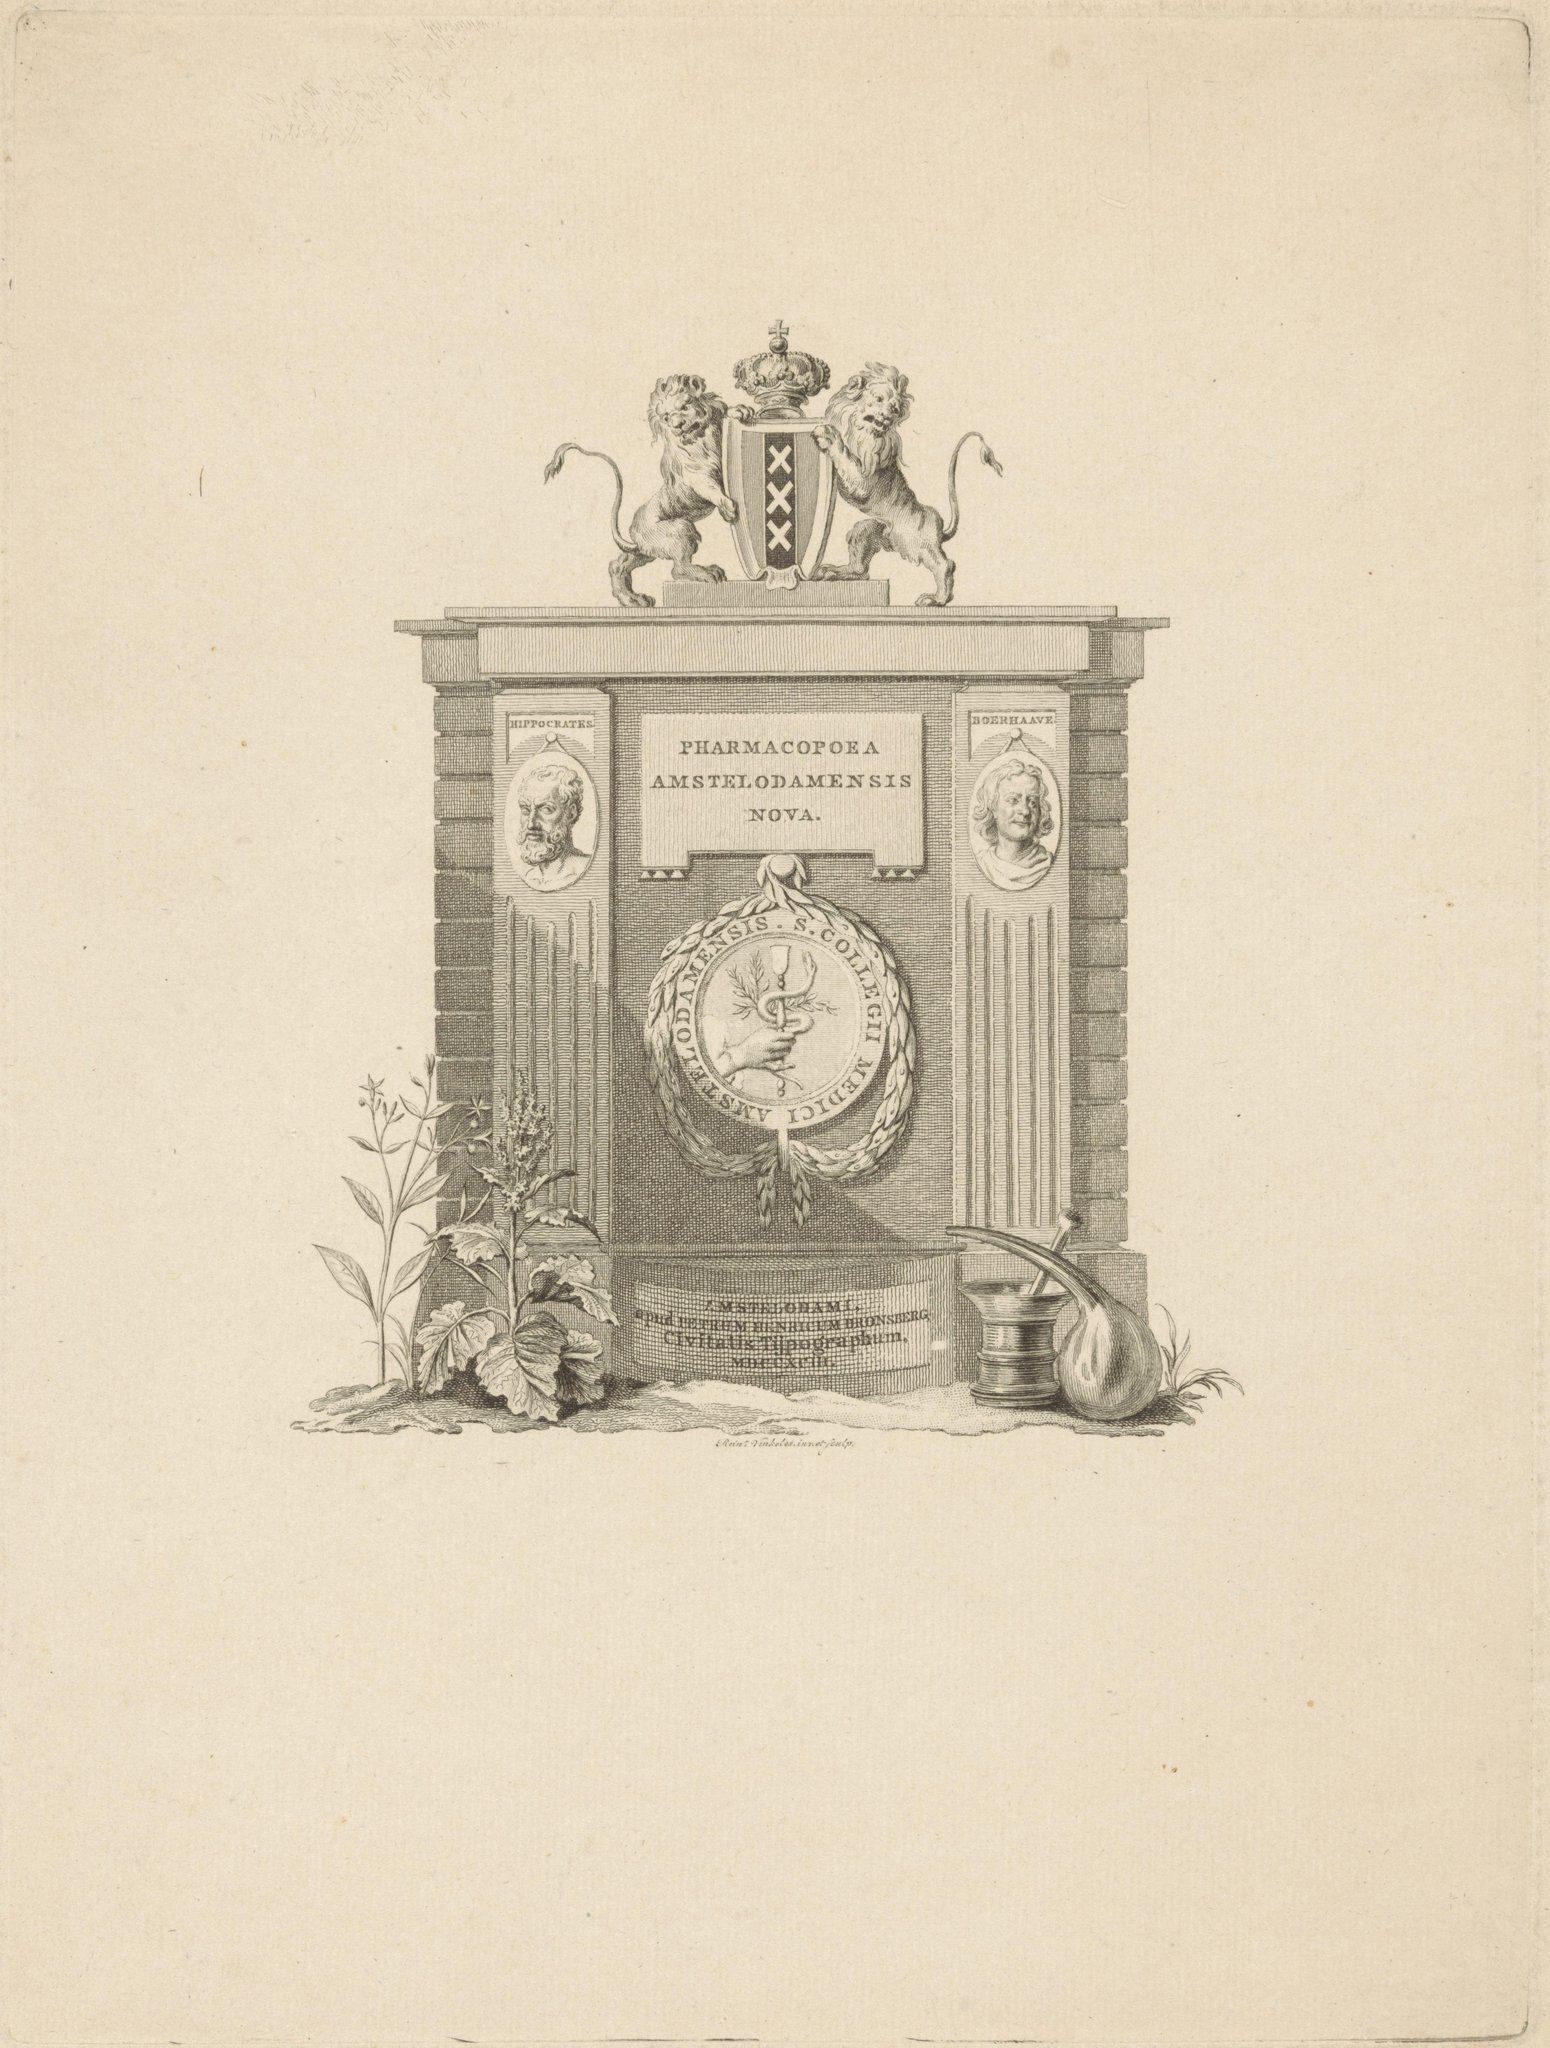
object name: titelblad, titelpagina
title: Titelpagina van de Pharmacopoea Amstelodamensis Nova, 1792-1793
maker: reinier vinkeles (i)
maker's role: draughtsman, print maker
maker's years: 1741-1816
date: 1792-1793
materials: paper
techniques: etching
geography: amsterdam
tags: hermanus boerhaave, pharmacy, pharmaceutics, (story of) hippocrates, amsterdam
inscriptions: collector's mark: Lugt 2228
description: Titelpagina voor de Pharmacopoea Amstelodamensis Nova, uitgegeven door P.H. Dronsberg, met in het adres het jaartal 1793. Allegorisch monument met opschrift, portretten van Hippocrates en Boerhaave, een embleem, planten en atrributen van de farmacie. Bekroond met het stadswapen van Amsterdam.